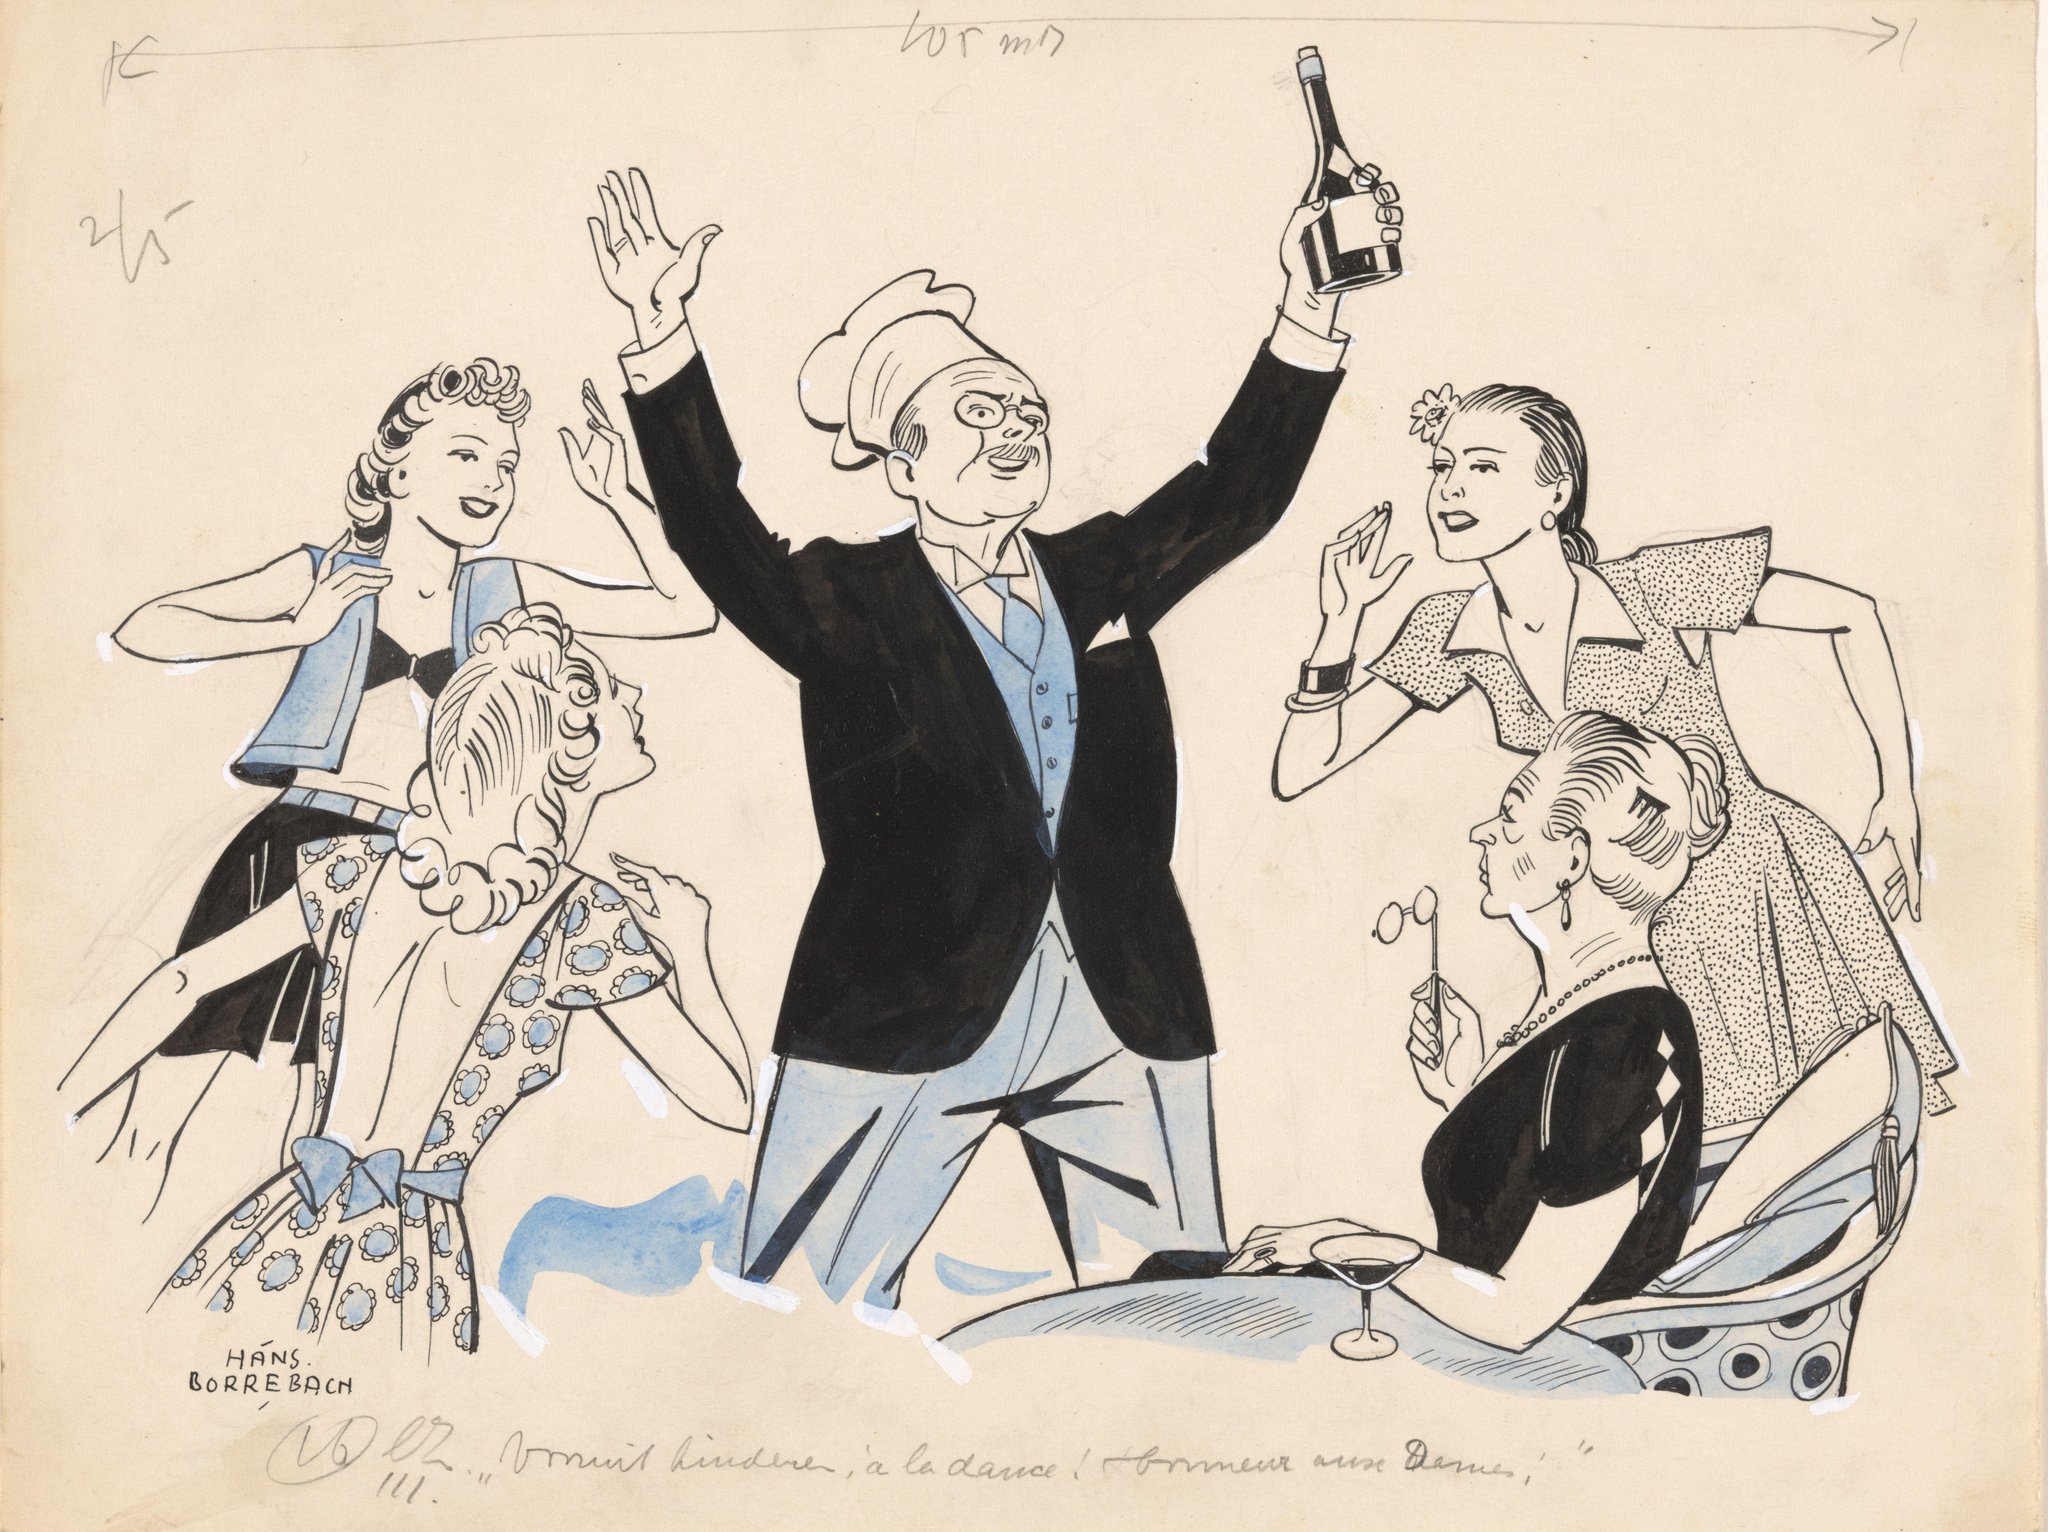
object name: drawing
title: Man houdt een fles drank in de lucht in gezelschap van vier vrouwen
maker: hans borrebach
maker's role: draughtsman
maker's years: 1903-1991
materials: paint, ink, paper, pencil, watercolor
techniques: brush, pen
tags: eyeglasses, spectacles, arm raised upward, dancing, alcoholic drinks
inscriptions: signature: ‘HANS./ BORREBACH’, collector's mark: Lugt 2228a, :, annotation: ‘16 bz/ 111/ "Vooruit kinderen, à la dance! Bonheur aux Dames."’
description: Een oudere man met een snor en muts staat bij een tafel en steekt beide handen in de lucht. In één hand houdt hij een fles drank. Een oudere vrouw aan tafel kijkt naar hem met een lorgnet in de hand. Drie jonge vrouwen dansen om het gezelschap heen.